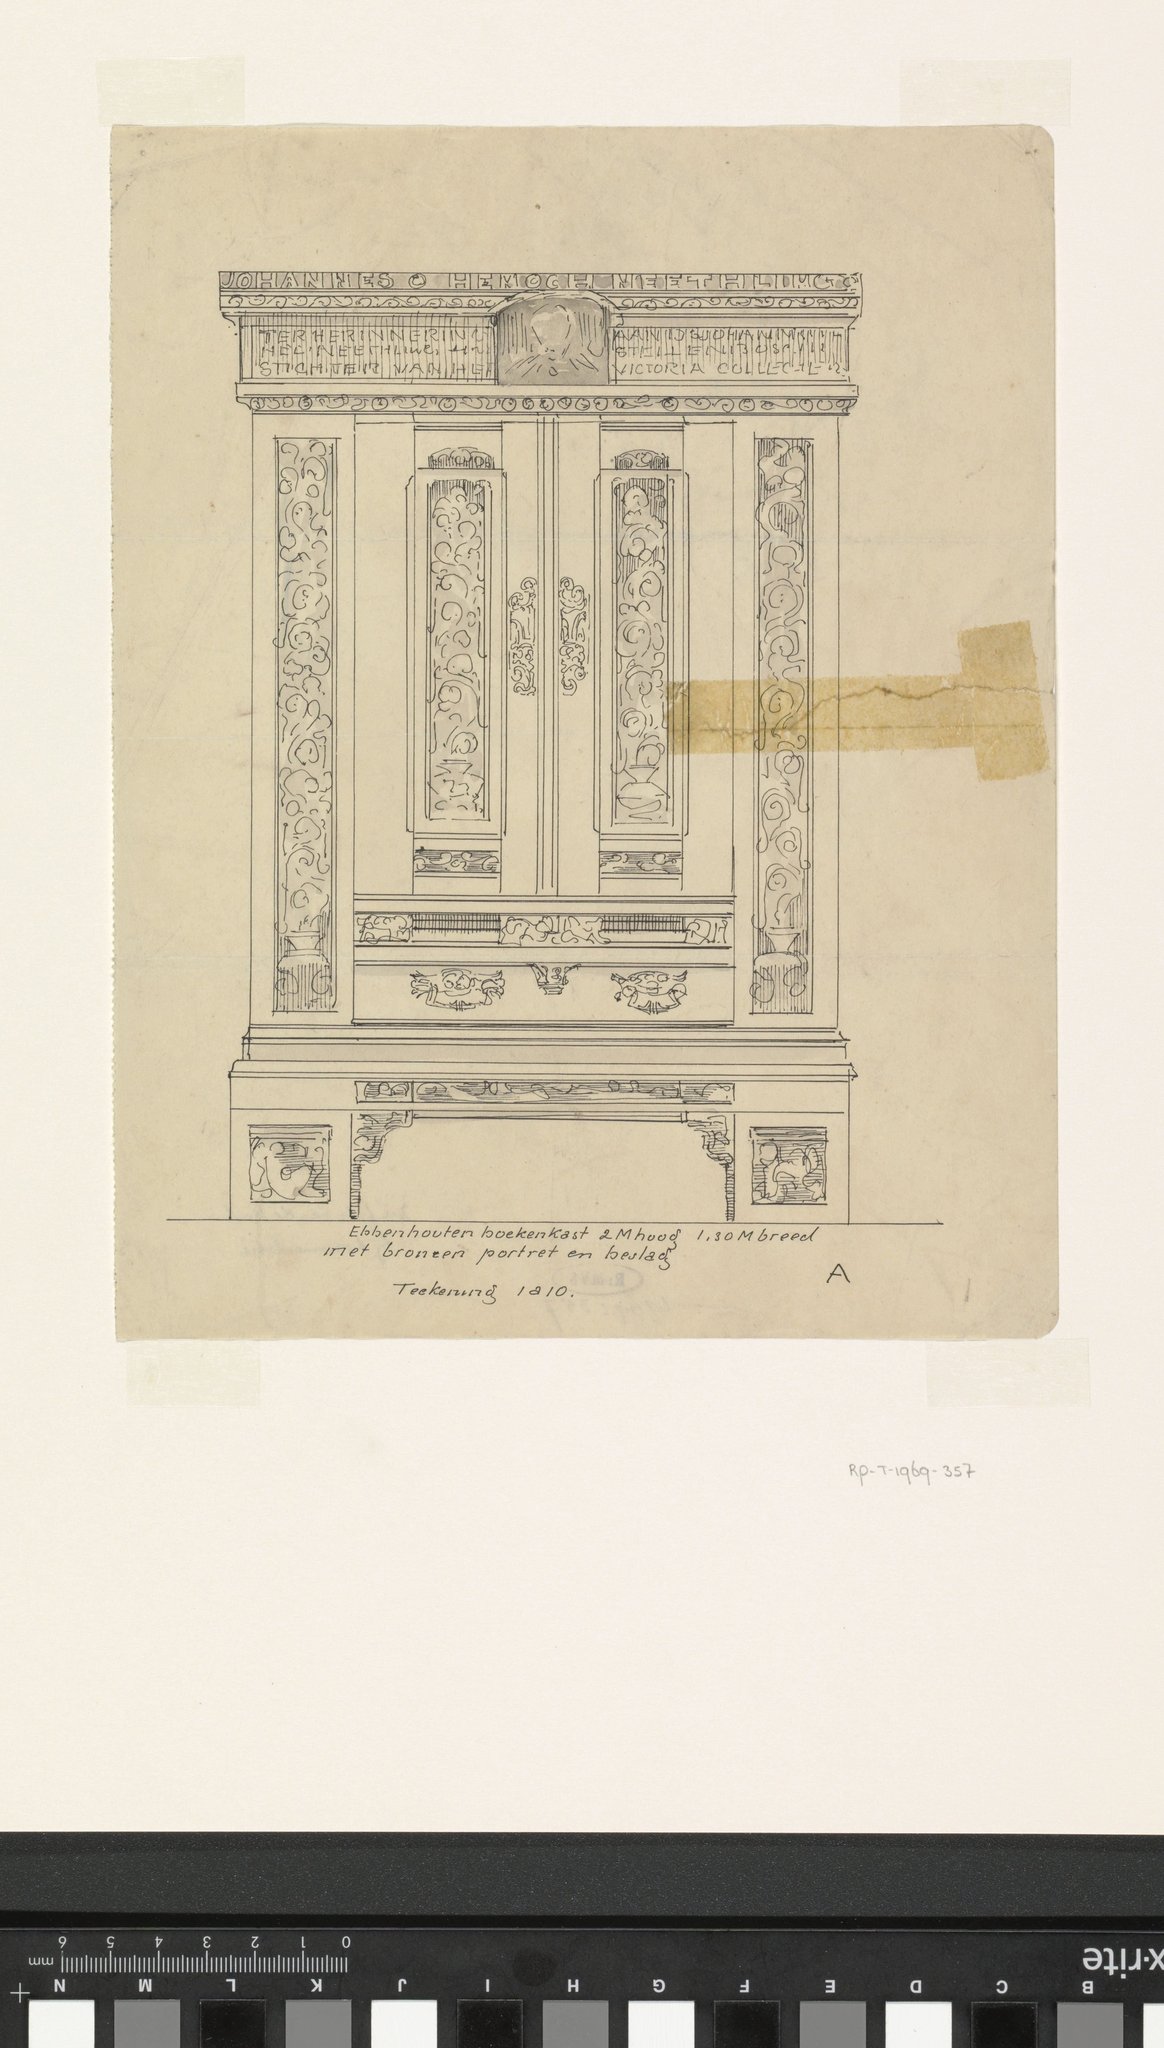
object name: drawing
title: Ontwerp voor een kast ter nagedachtenis aan J.H. Neethling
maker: carel adolph lion cachet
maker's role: draughtsman, print maker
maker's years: 1864-1945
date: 1874-1945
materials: ink, paper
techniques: pen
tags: book, cupboard